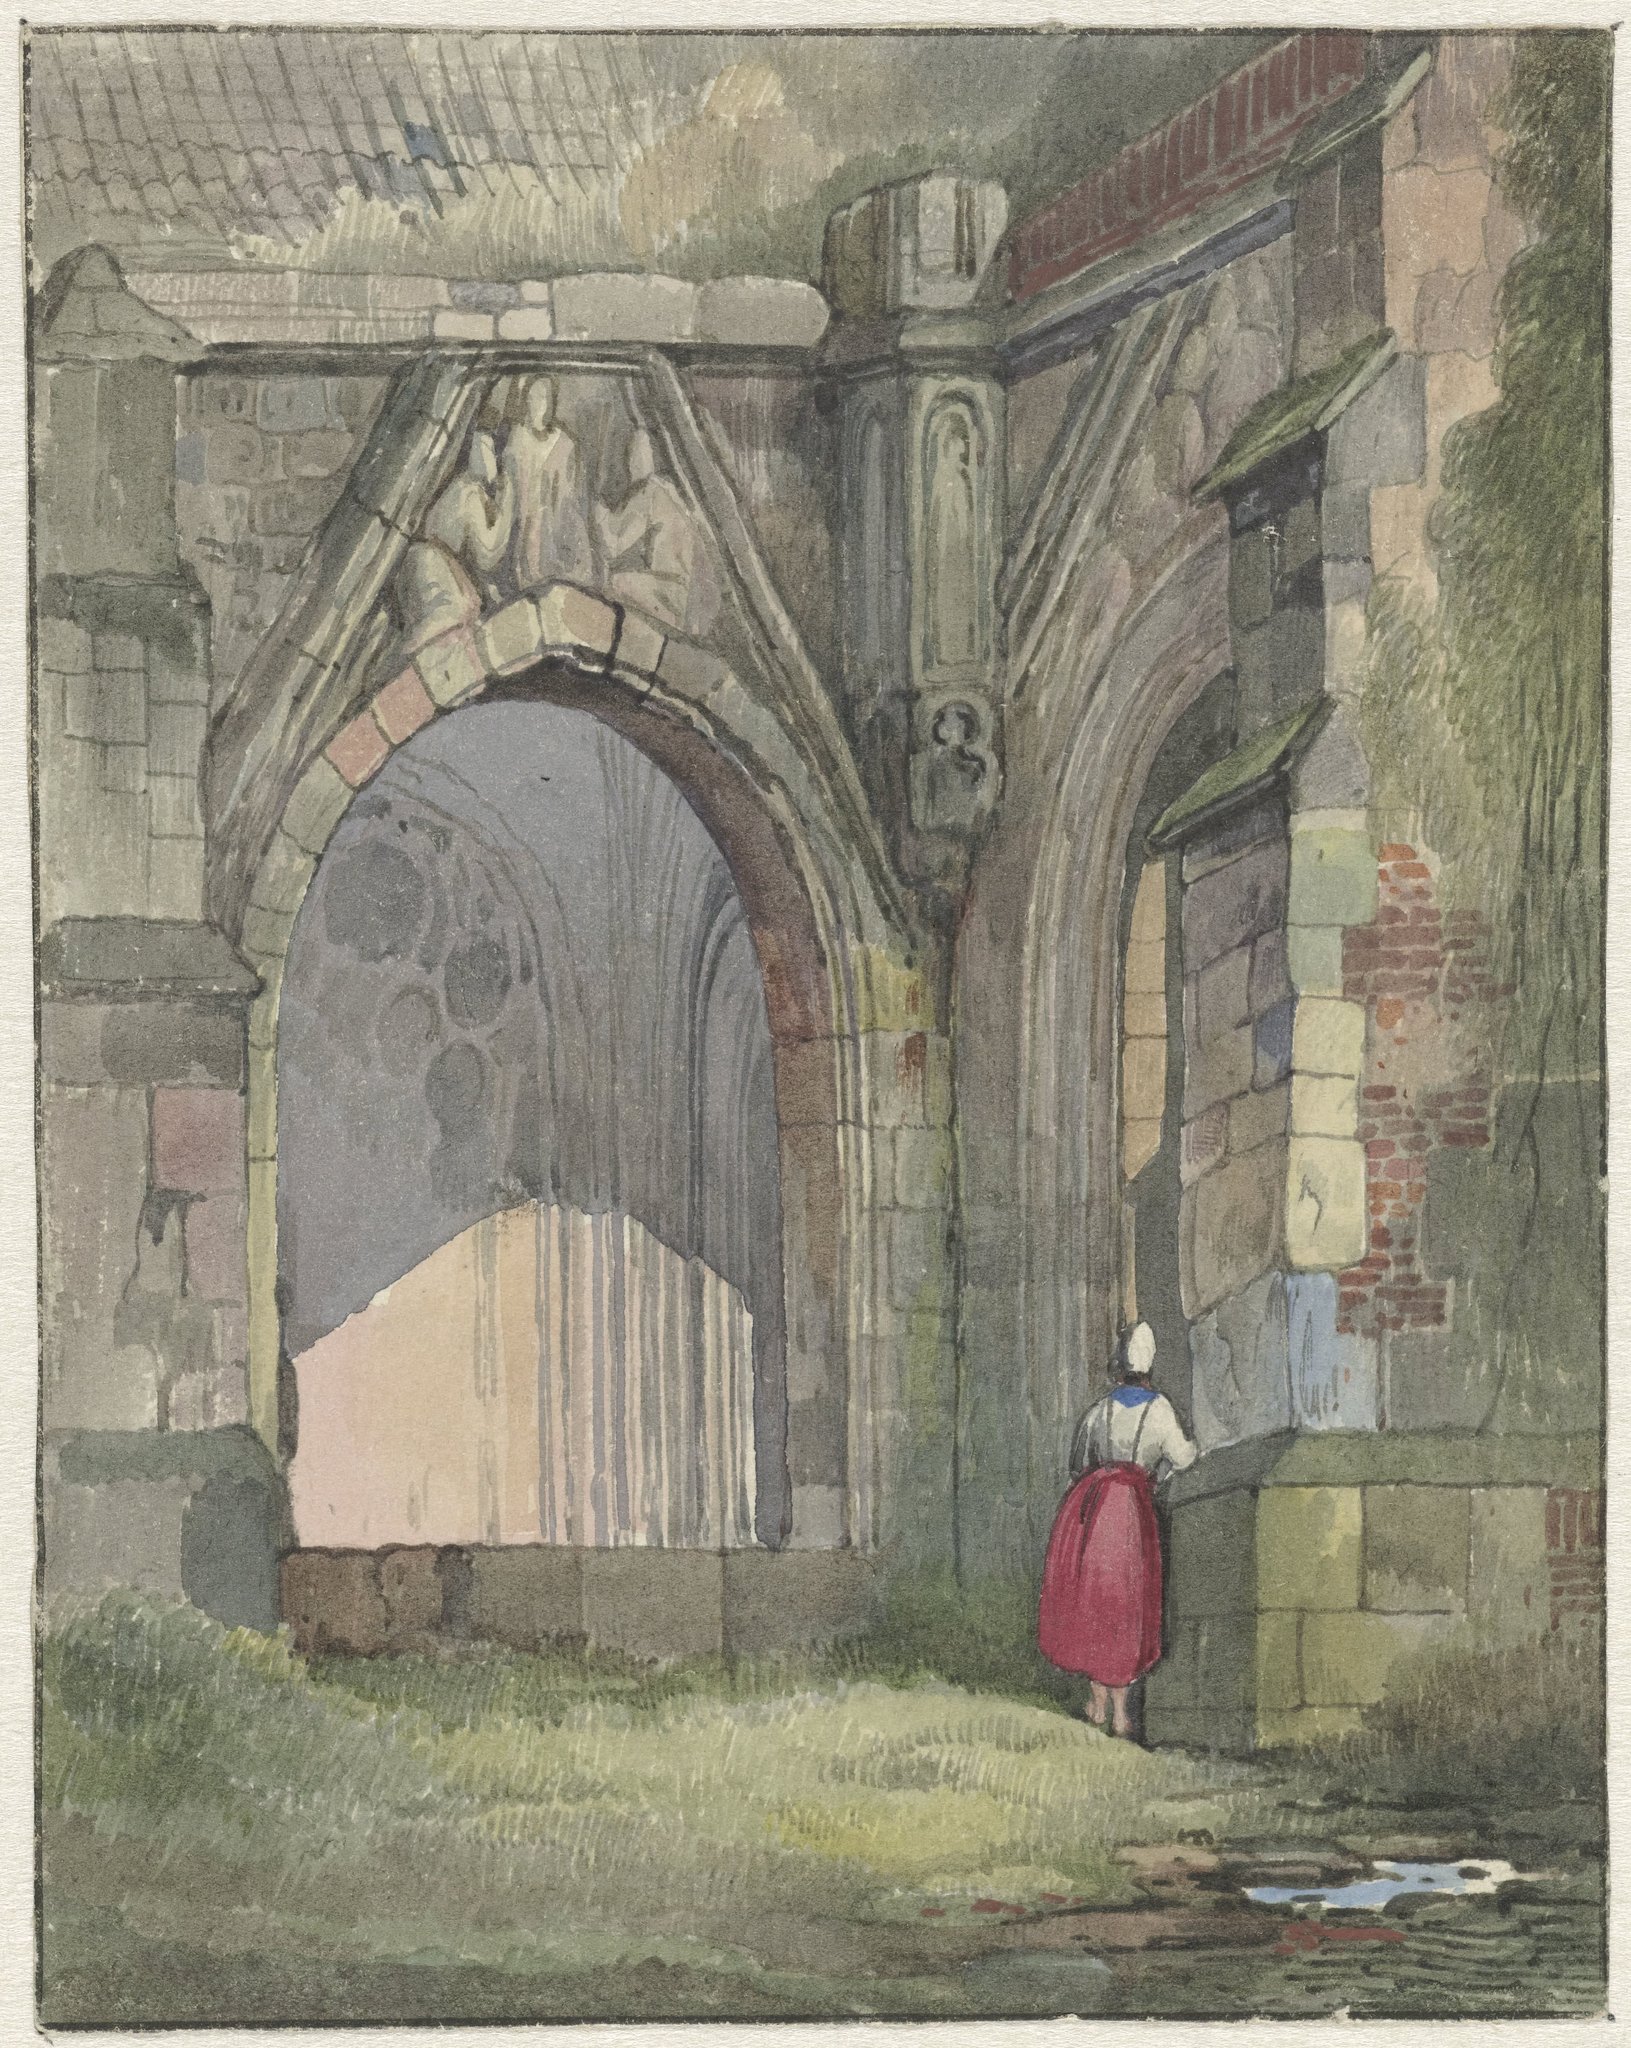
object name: drawing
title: Kerkportaal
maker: reinier craeyvanger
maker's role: draughtsman, print maker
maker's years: 1812-1880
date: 1822-1880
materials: paper, watercolor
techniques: brush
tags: parts of church exterior and annexes: porch